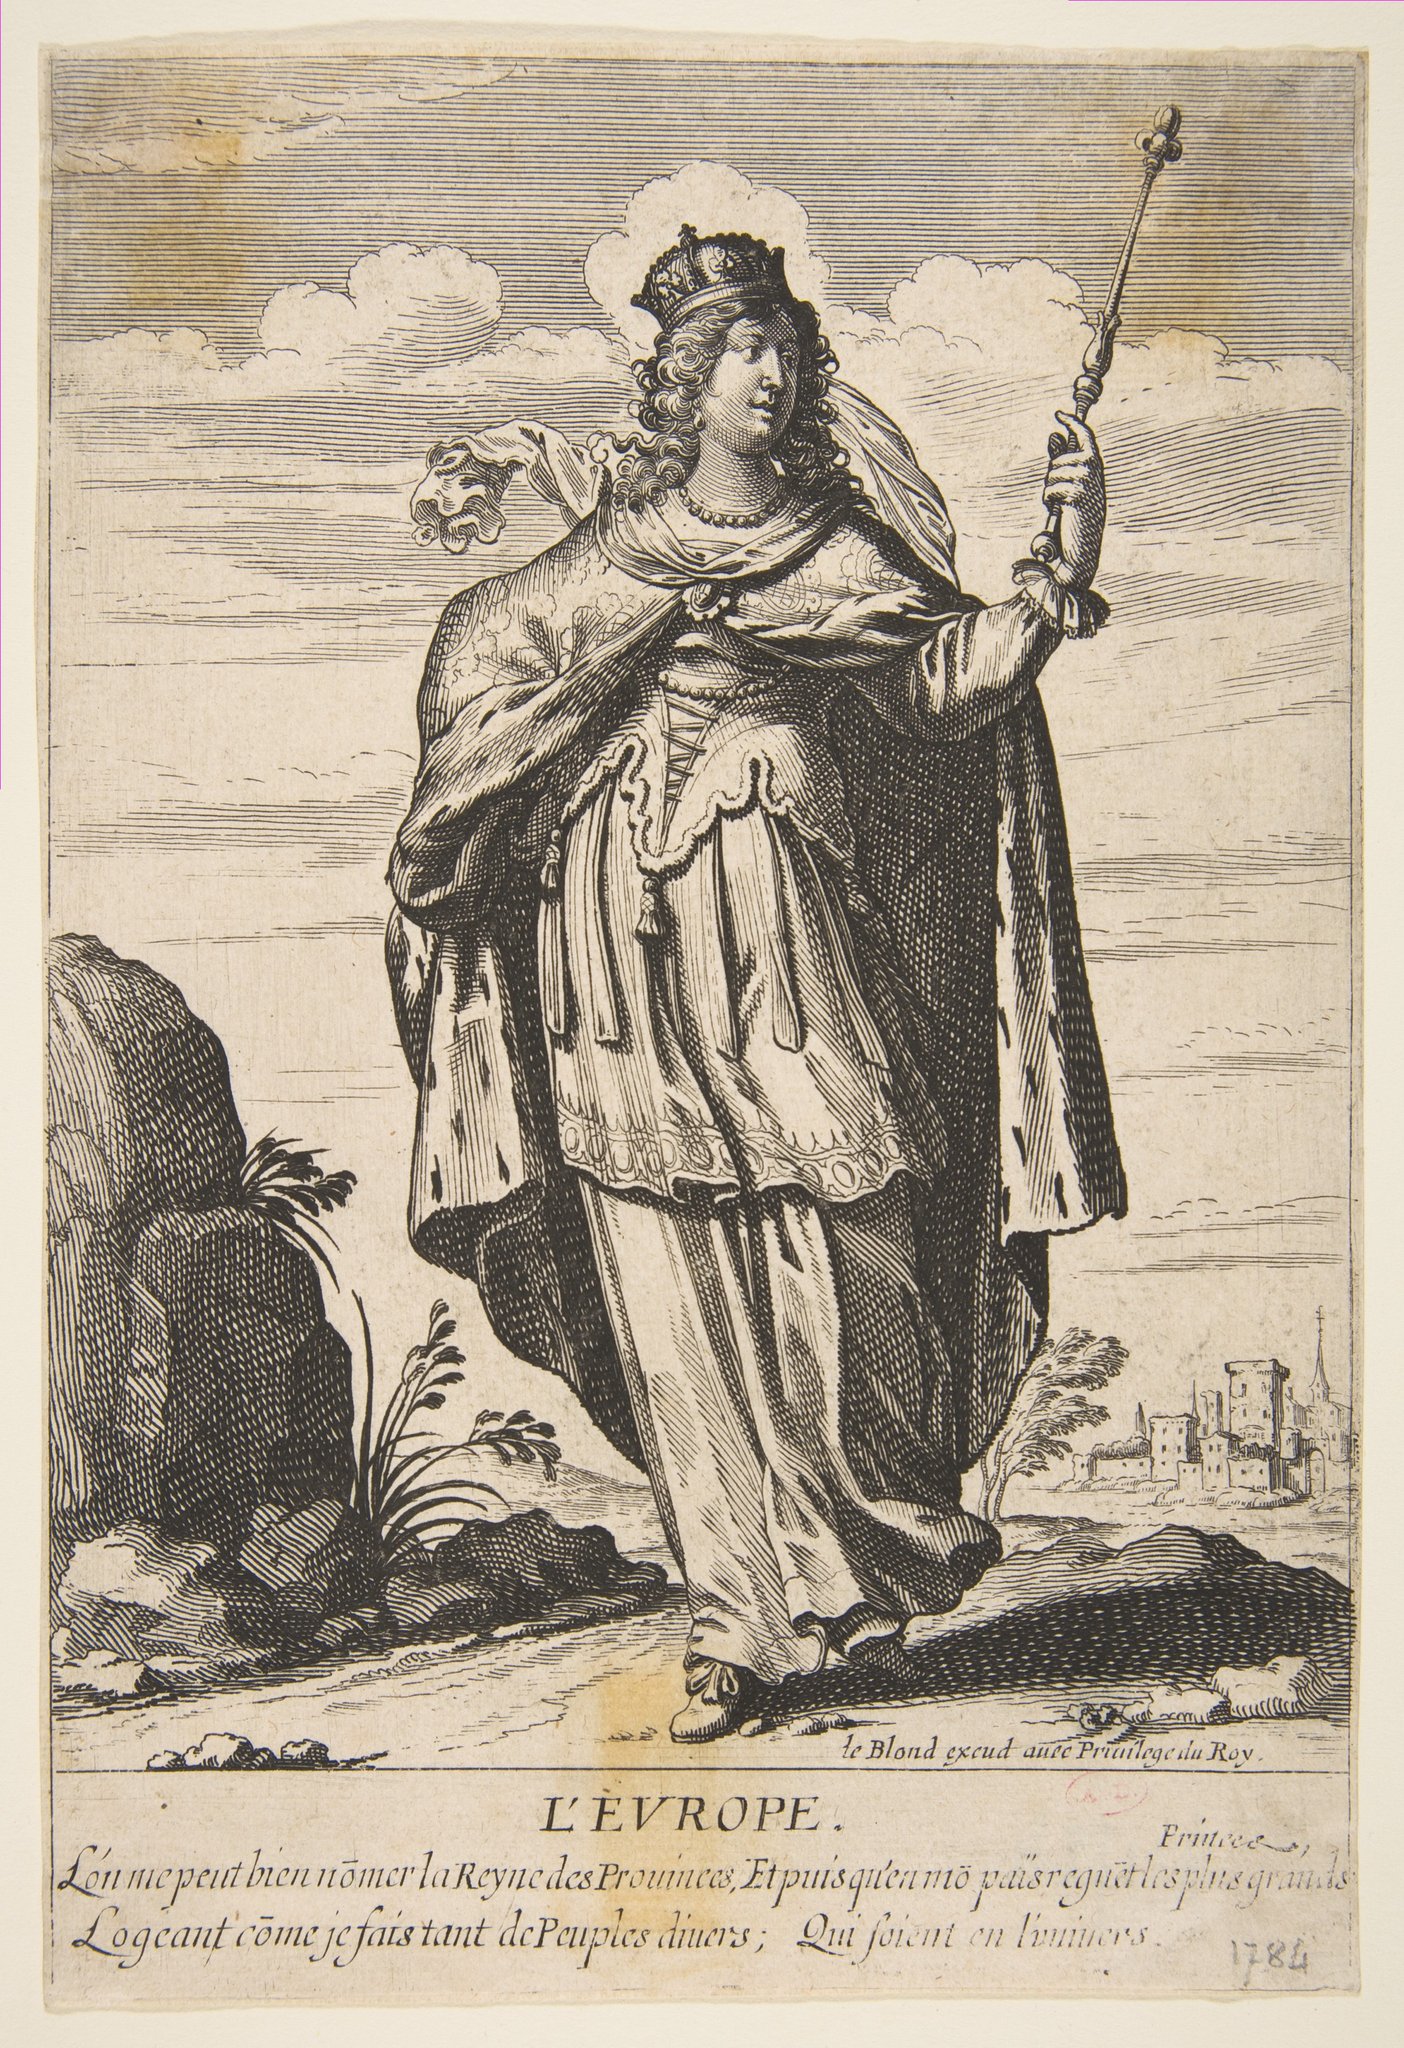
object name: print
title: Allegory of Europe, from "The Four Continents"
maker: abraham bosse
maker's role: artist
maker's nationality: french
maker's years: 1602-1676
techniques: etching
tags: women